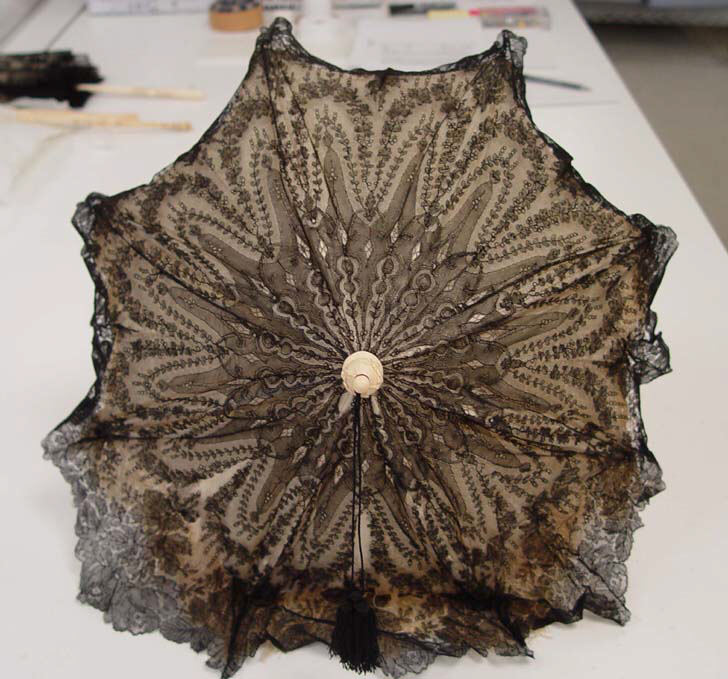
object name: parasol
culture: french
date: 1834-1866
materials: ivory, silk